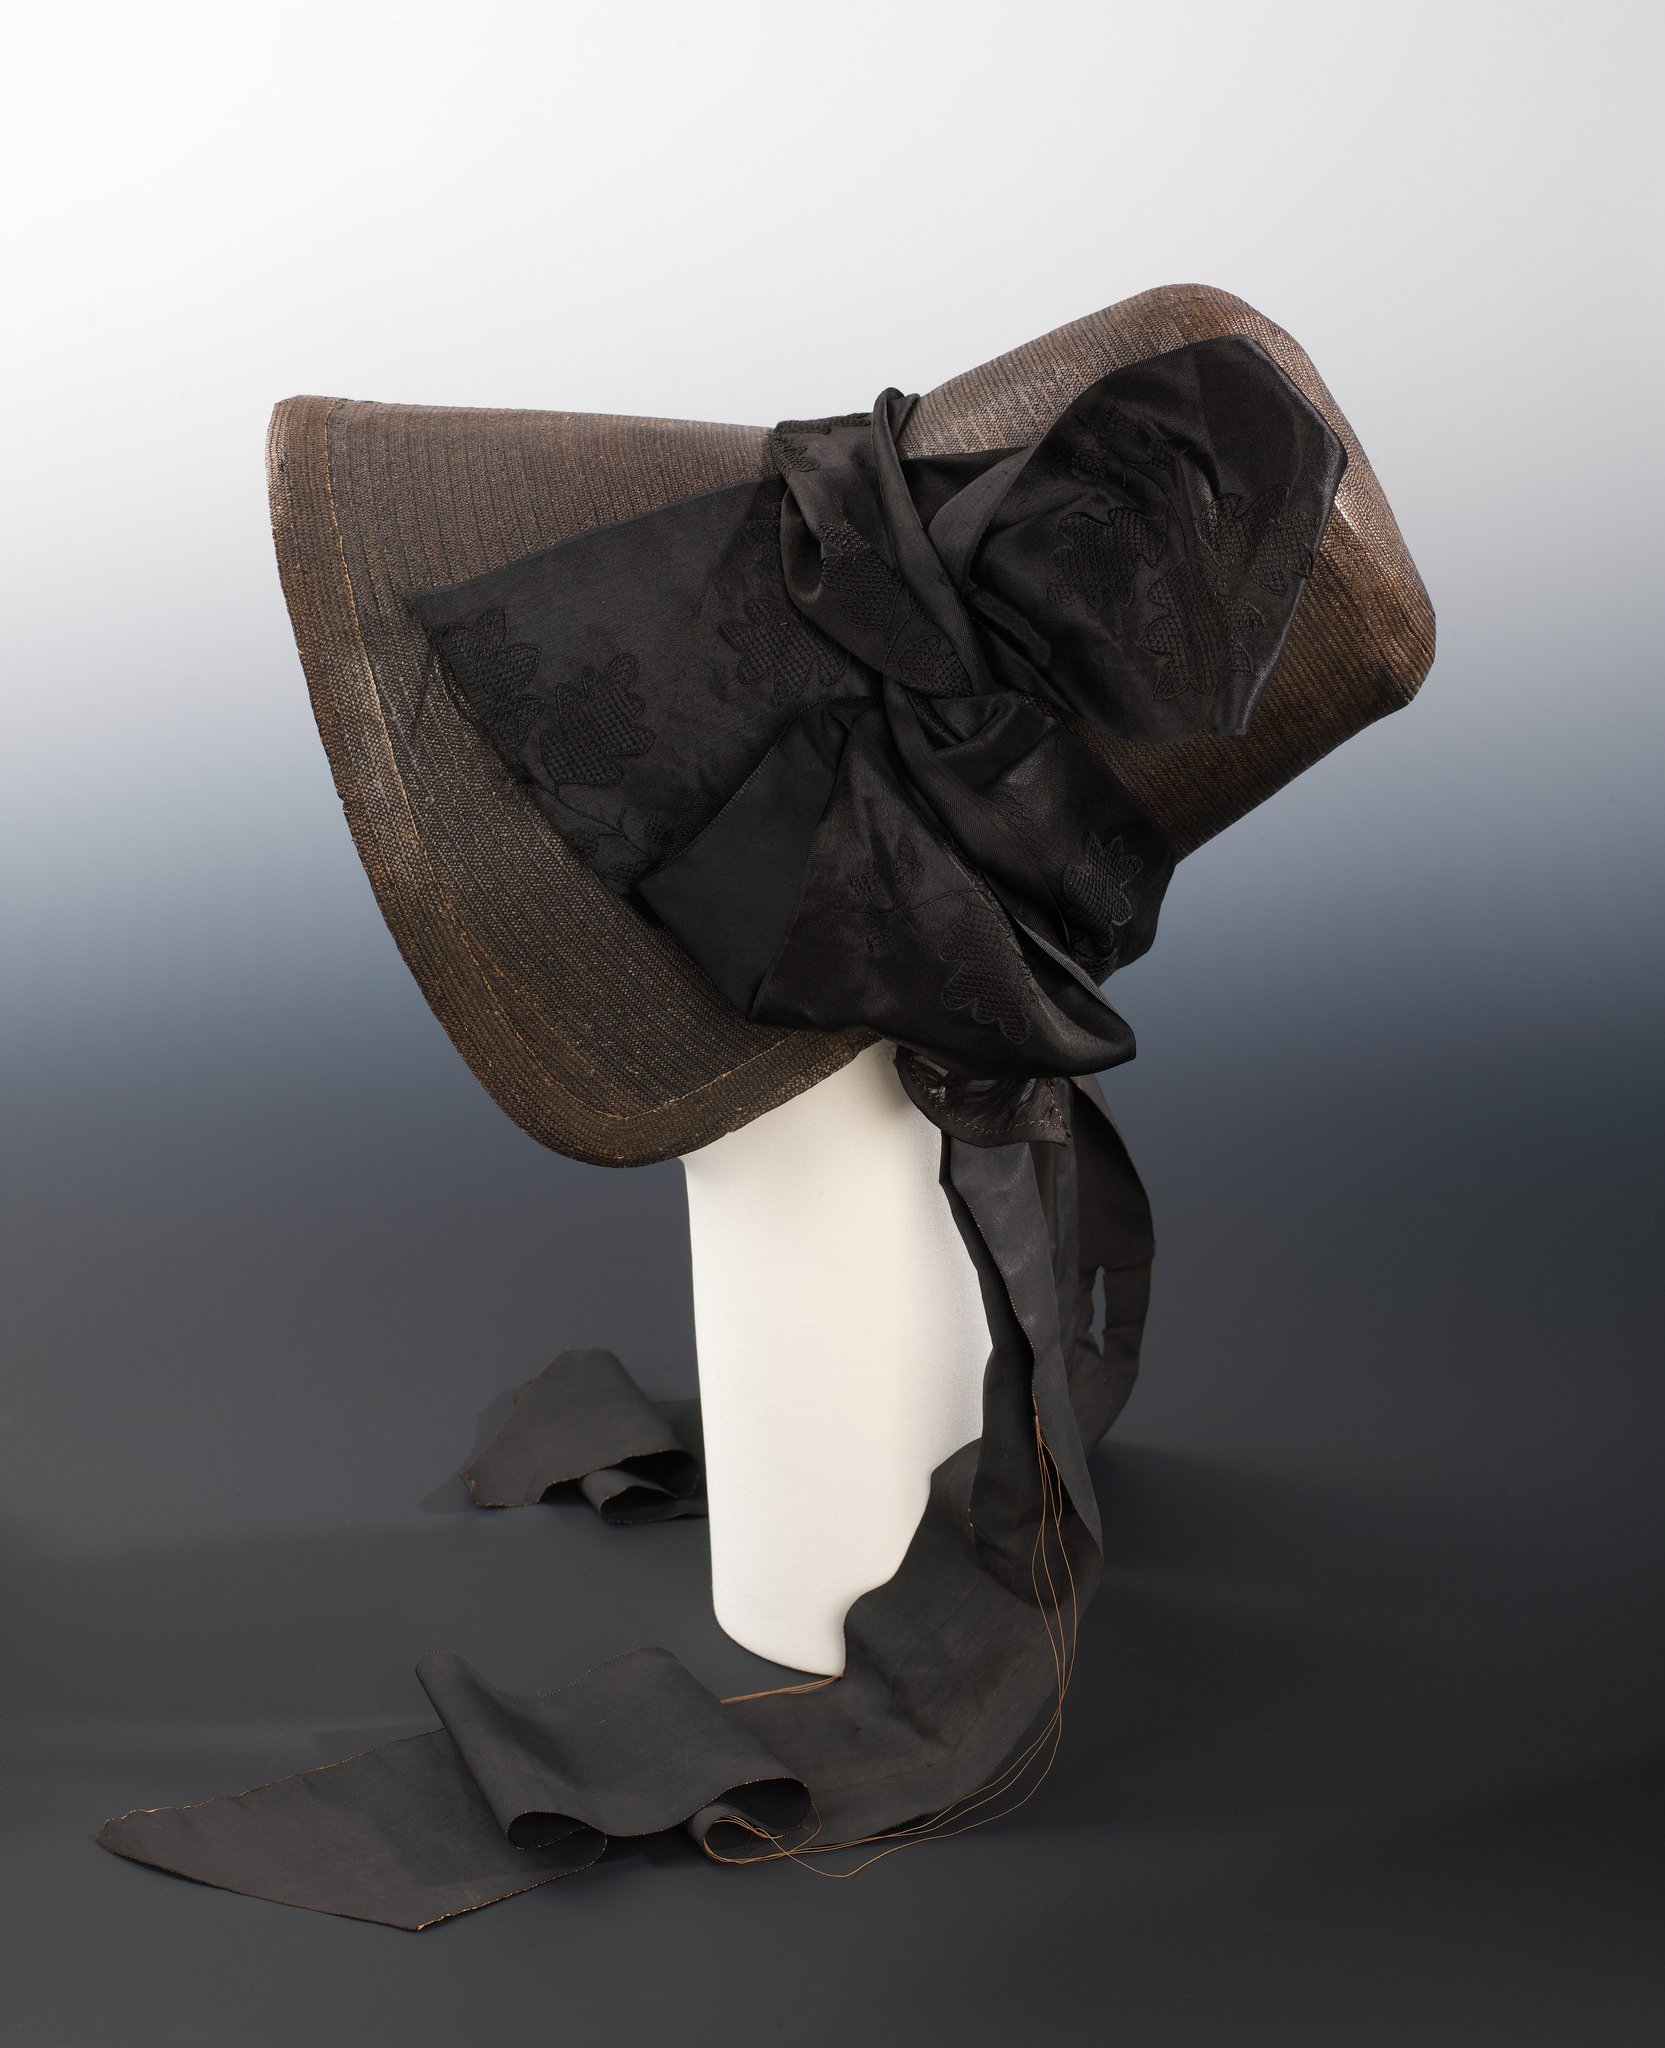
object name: mourning poke bonnet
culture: american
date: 1840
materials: silk, fiber